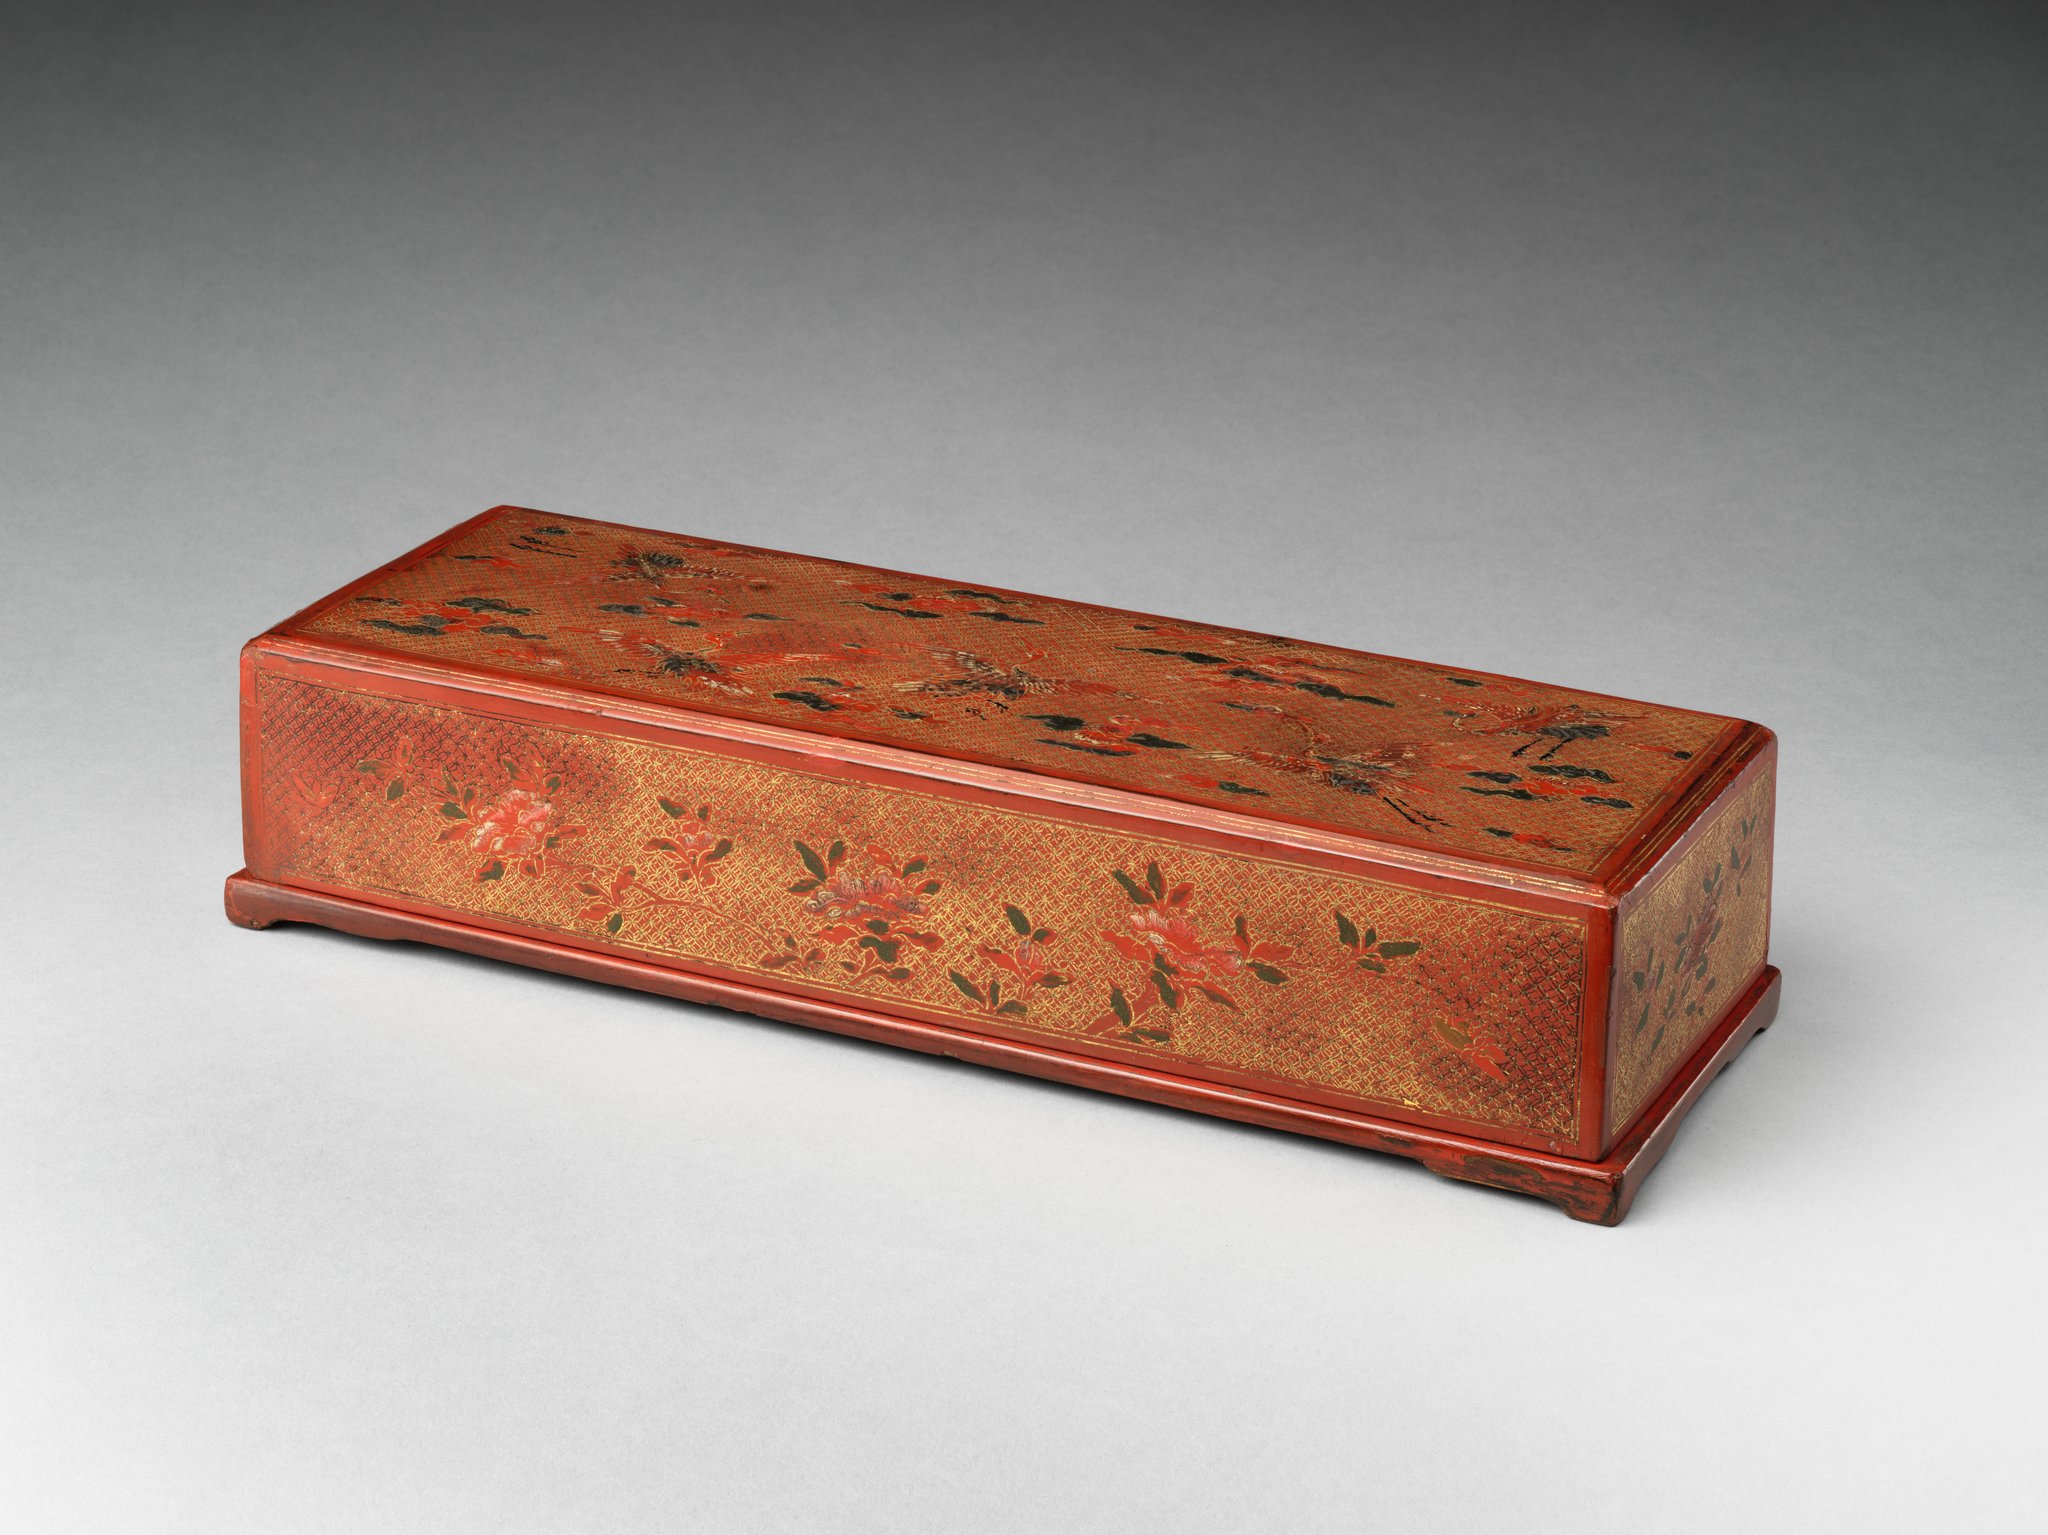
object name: box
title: Rectangular writing box with decoration of clouds and cranes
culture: japanese or ryukyuan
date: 1601-1700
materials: gold, lacquer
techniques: engraving, painting